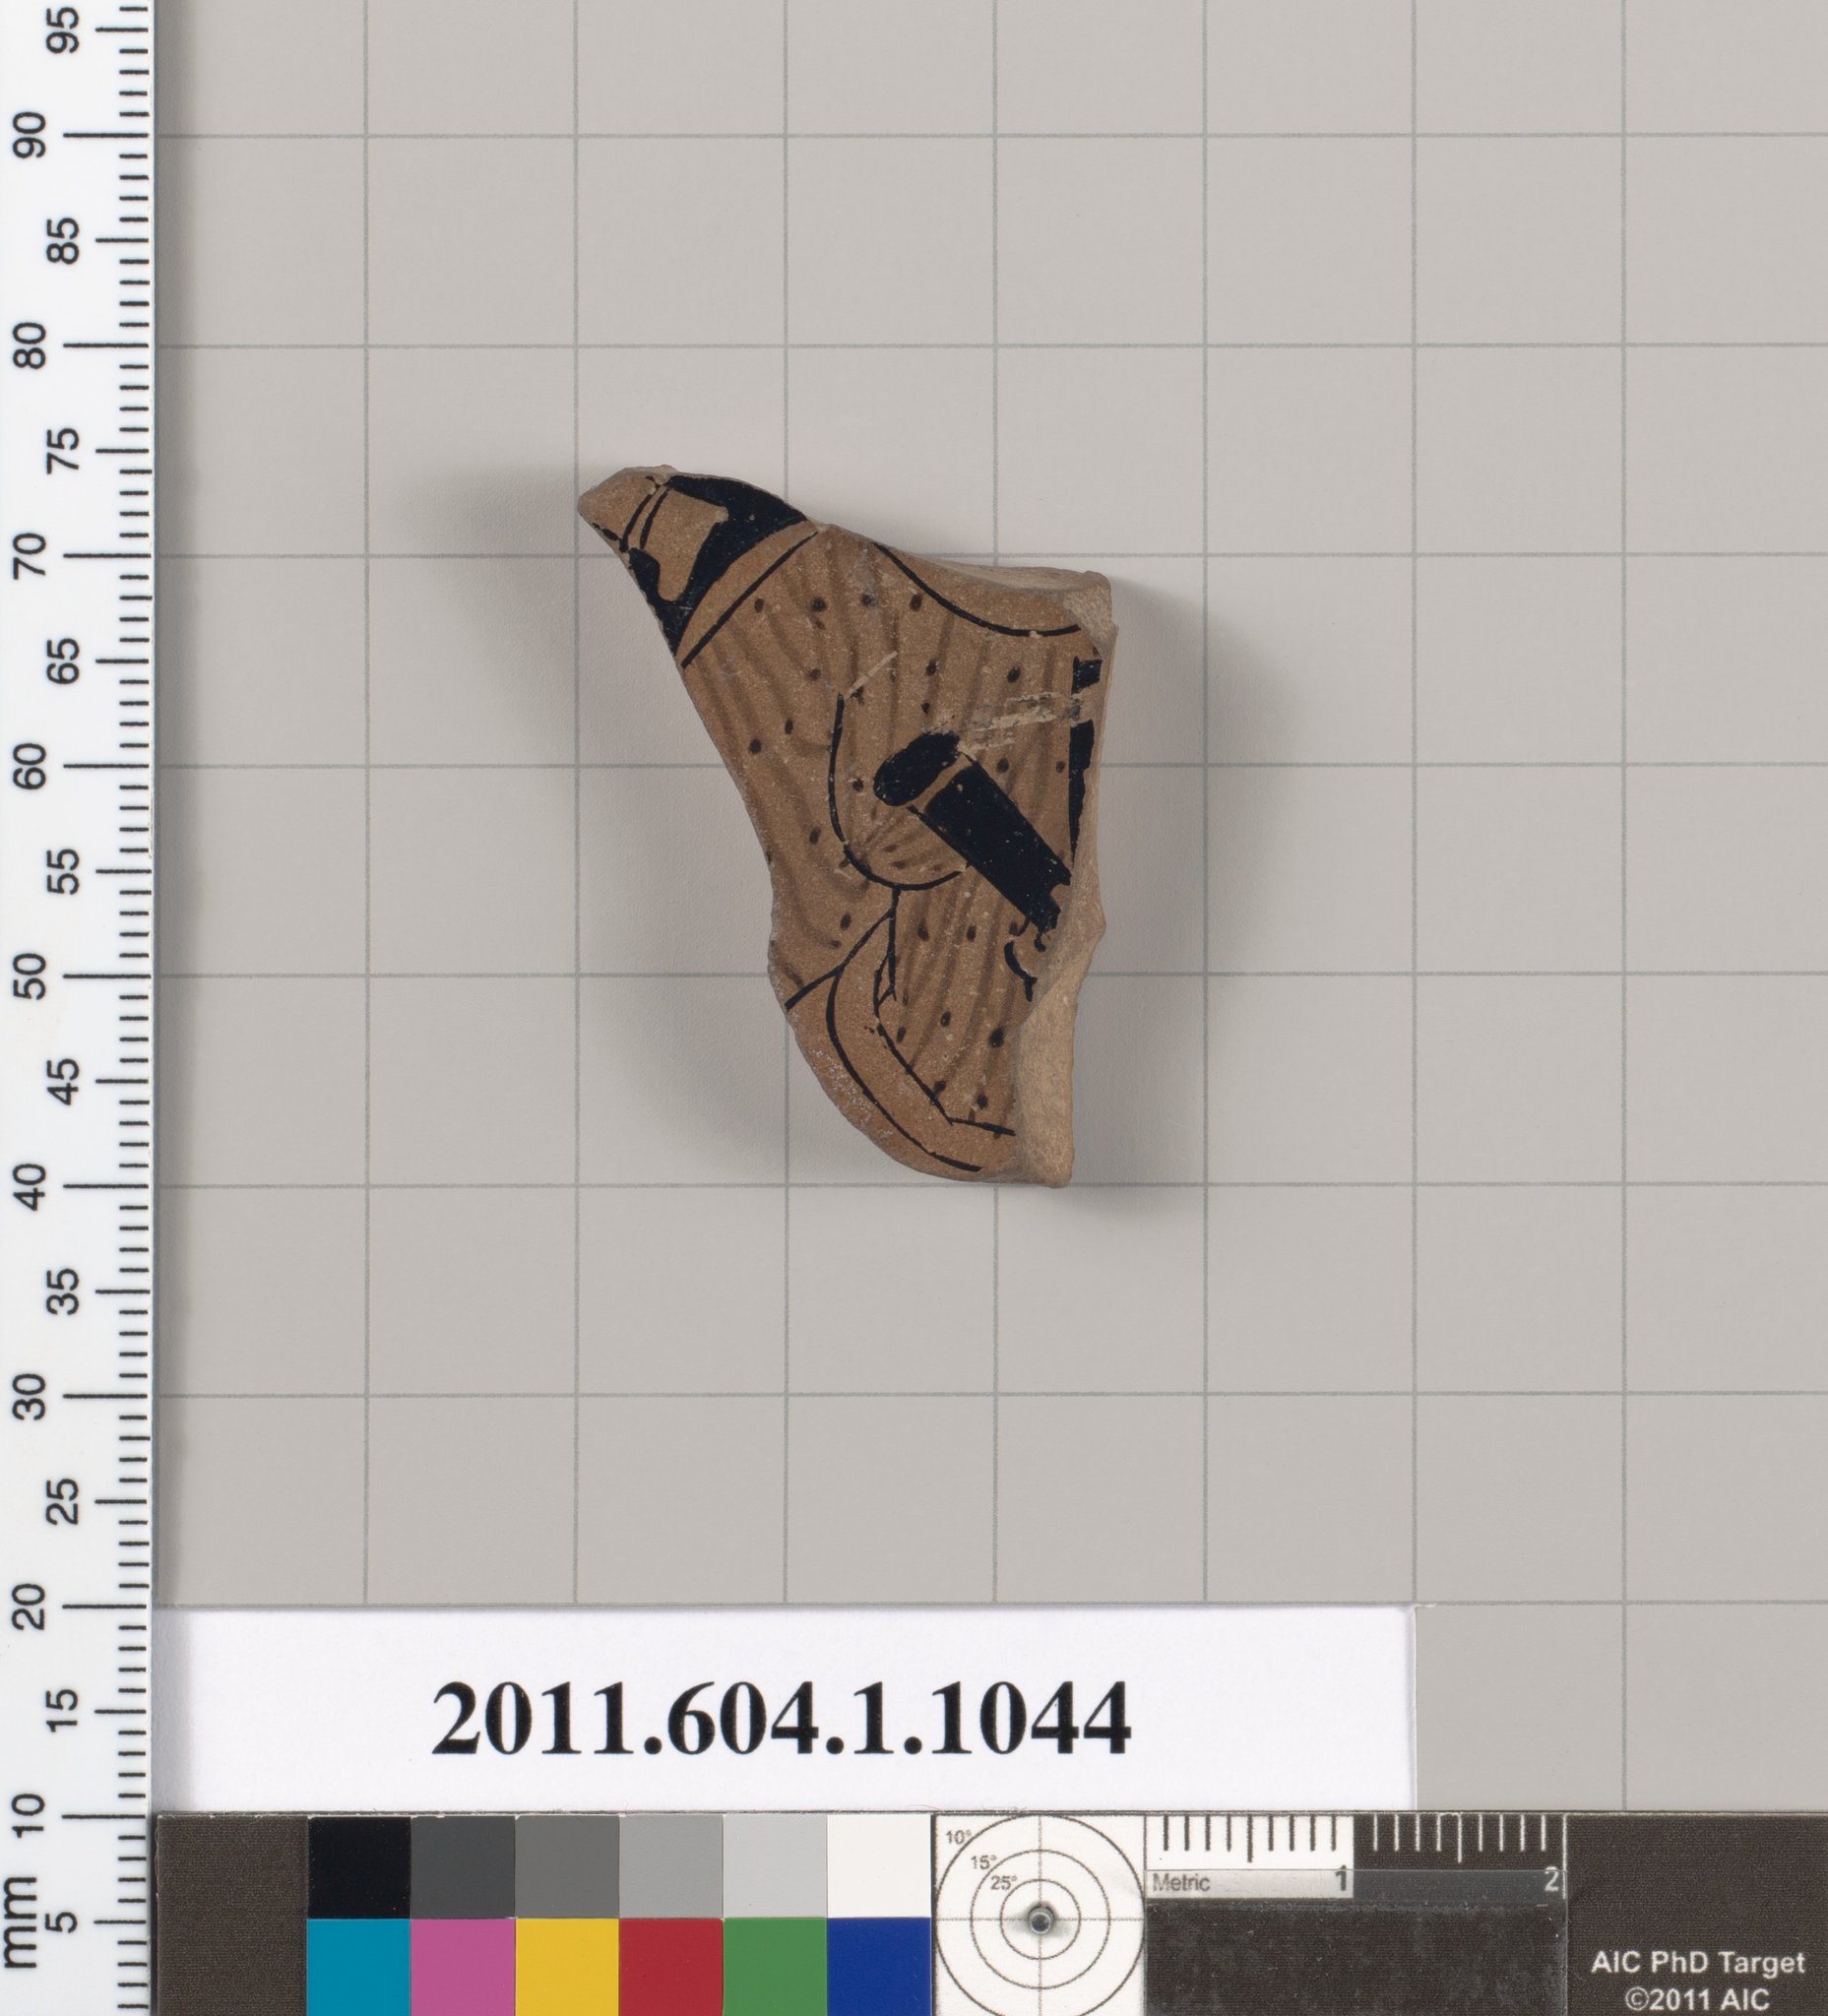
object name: kylix fragment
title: Terracotta fragment of a kylix (drinking cup)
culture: greek, attic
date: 490-480 BCE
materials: terracotta